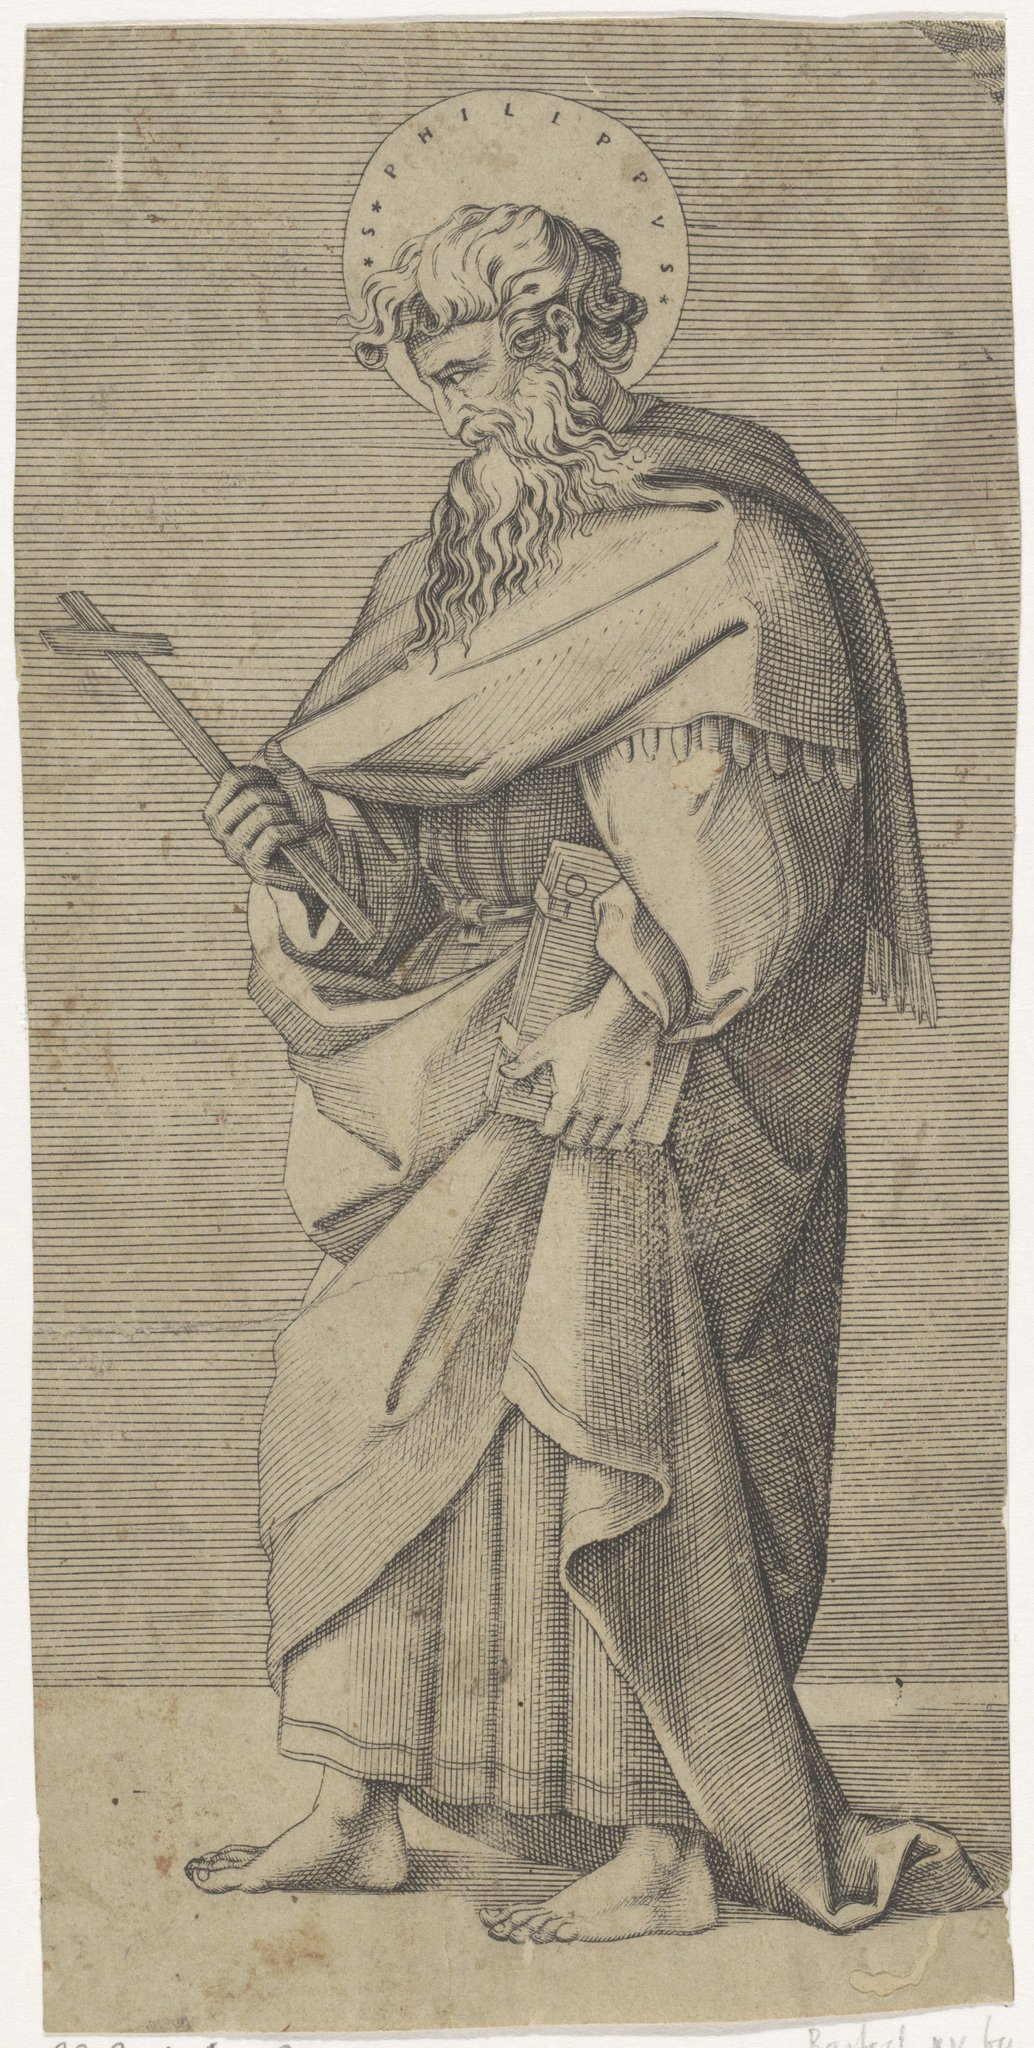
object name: print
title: S Phillppvs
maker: marcantonio raimondi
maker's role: print maker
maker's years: 1470-1534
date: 1517-1527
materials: paper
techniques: engraving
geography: rome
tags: the apostle philip; possible attributes: book, cross, dish with snake, lance, scroll, stone, sword